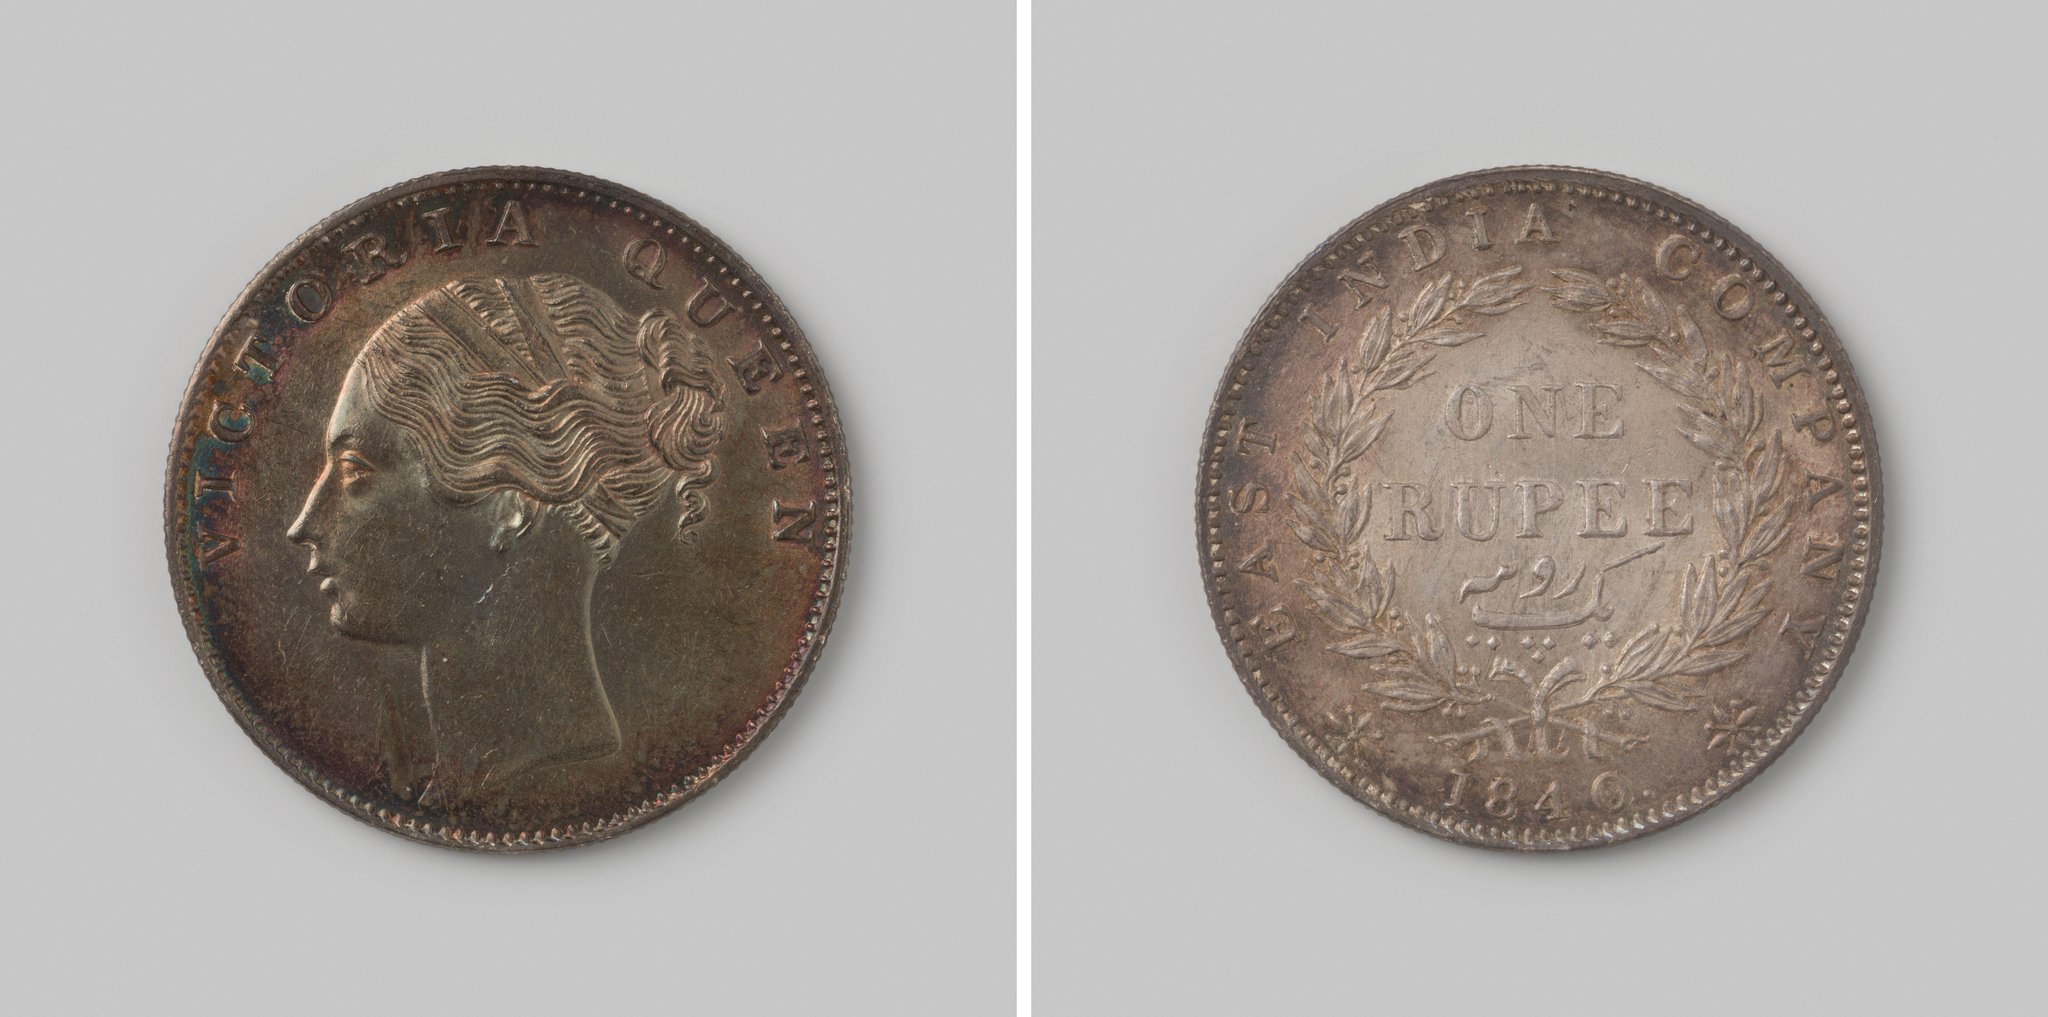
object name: coin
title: Roepie uit India van de Engelse Oostindische Compagnie (EIC) op naam van koningin Victoria,1840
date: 1840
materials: silver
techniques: striking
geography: kolkata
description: Zilveren munt. Voorzijde: hoofd van koningin Victoria naar links. Omschrift aaneengesloten. Keerzijde: tussen twee samengebonden takken in twee regels waarde-aanduiding: one rupee, waaronder in Arabische lettertekens in een regel waarde-aanduiding. Onderaan jaartal. Op lint links boven kleine opkomende maan [ = Calcutta]. Kartelrand.